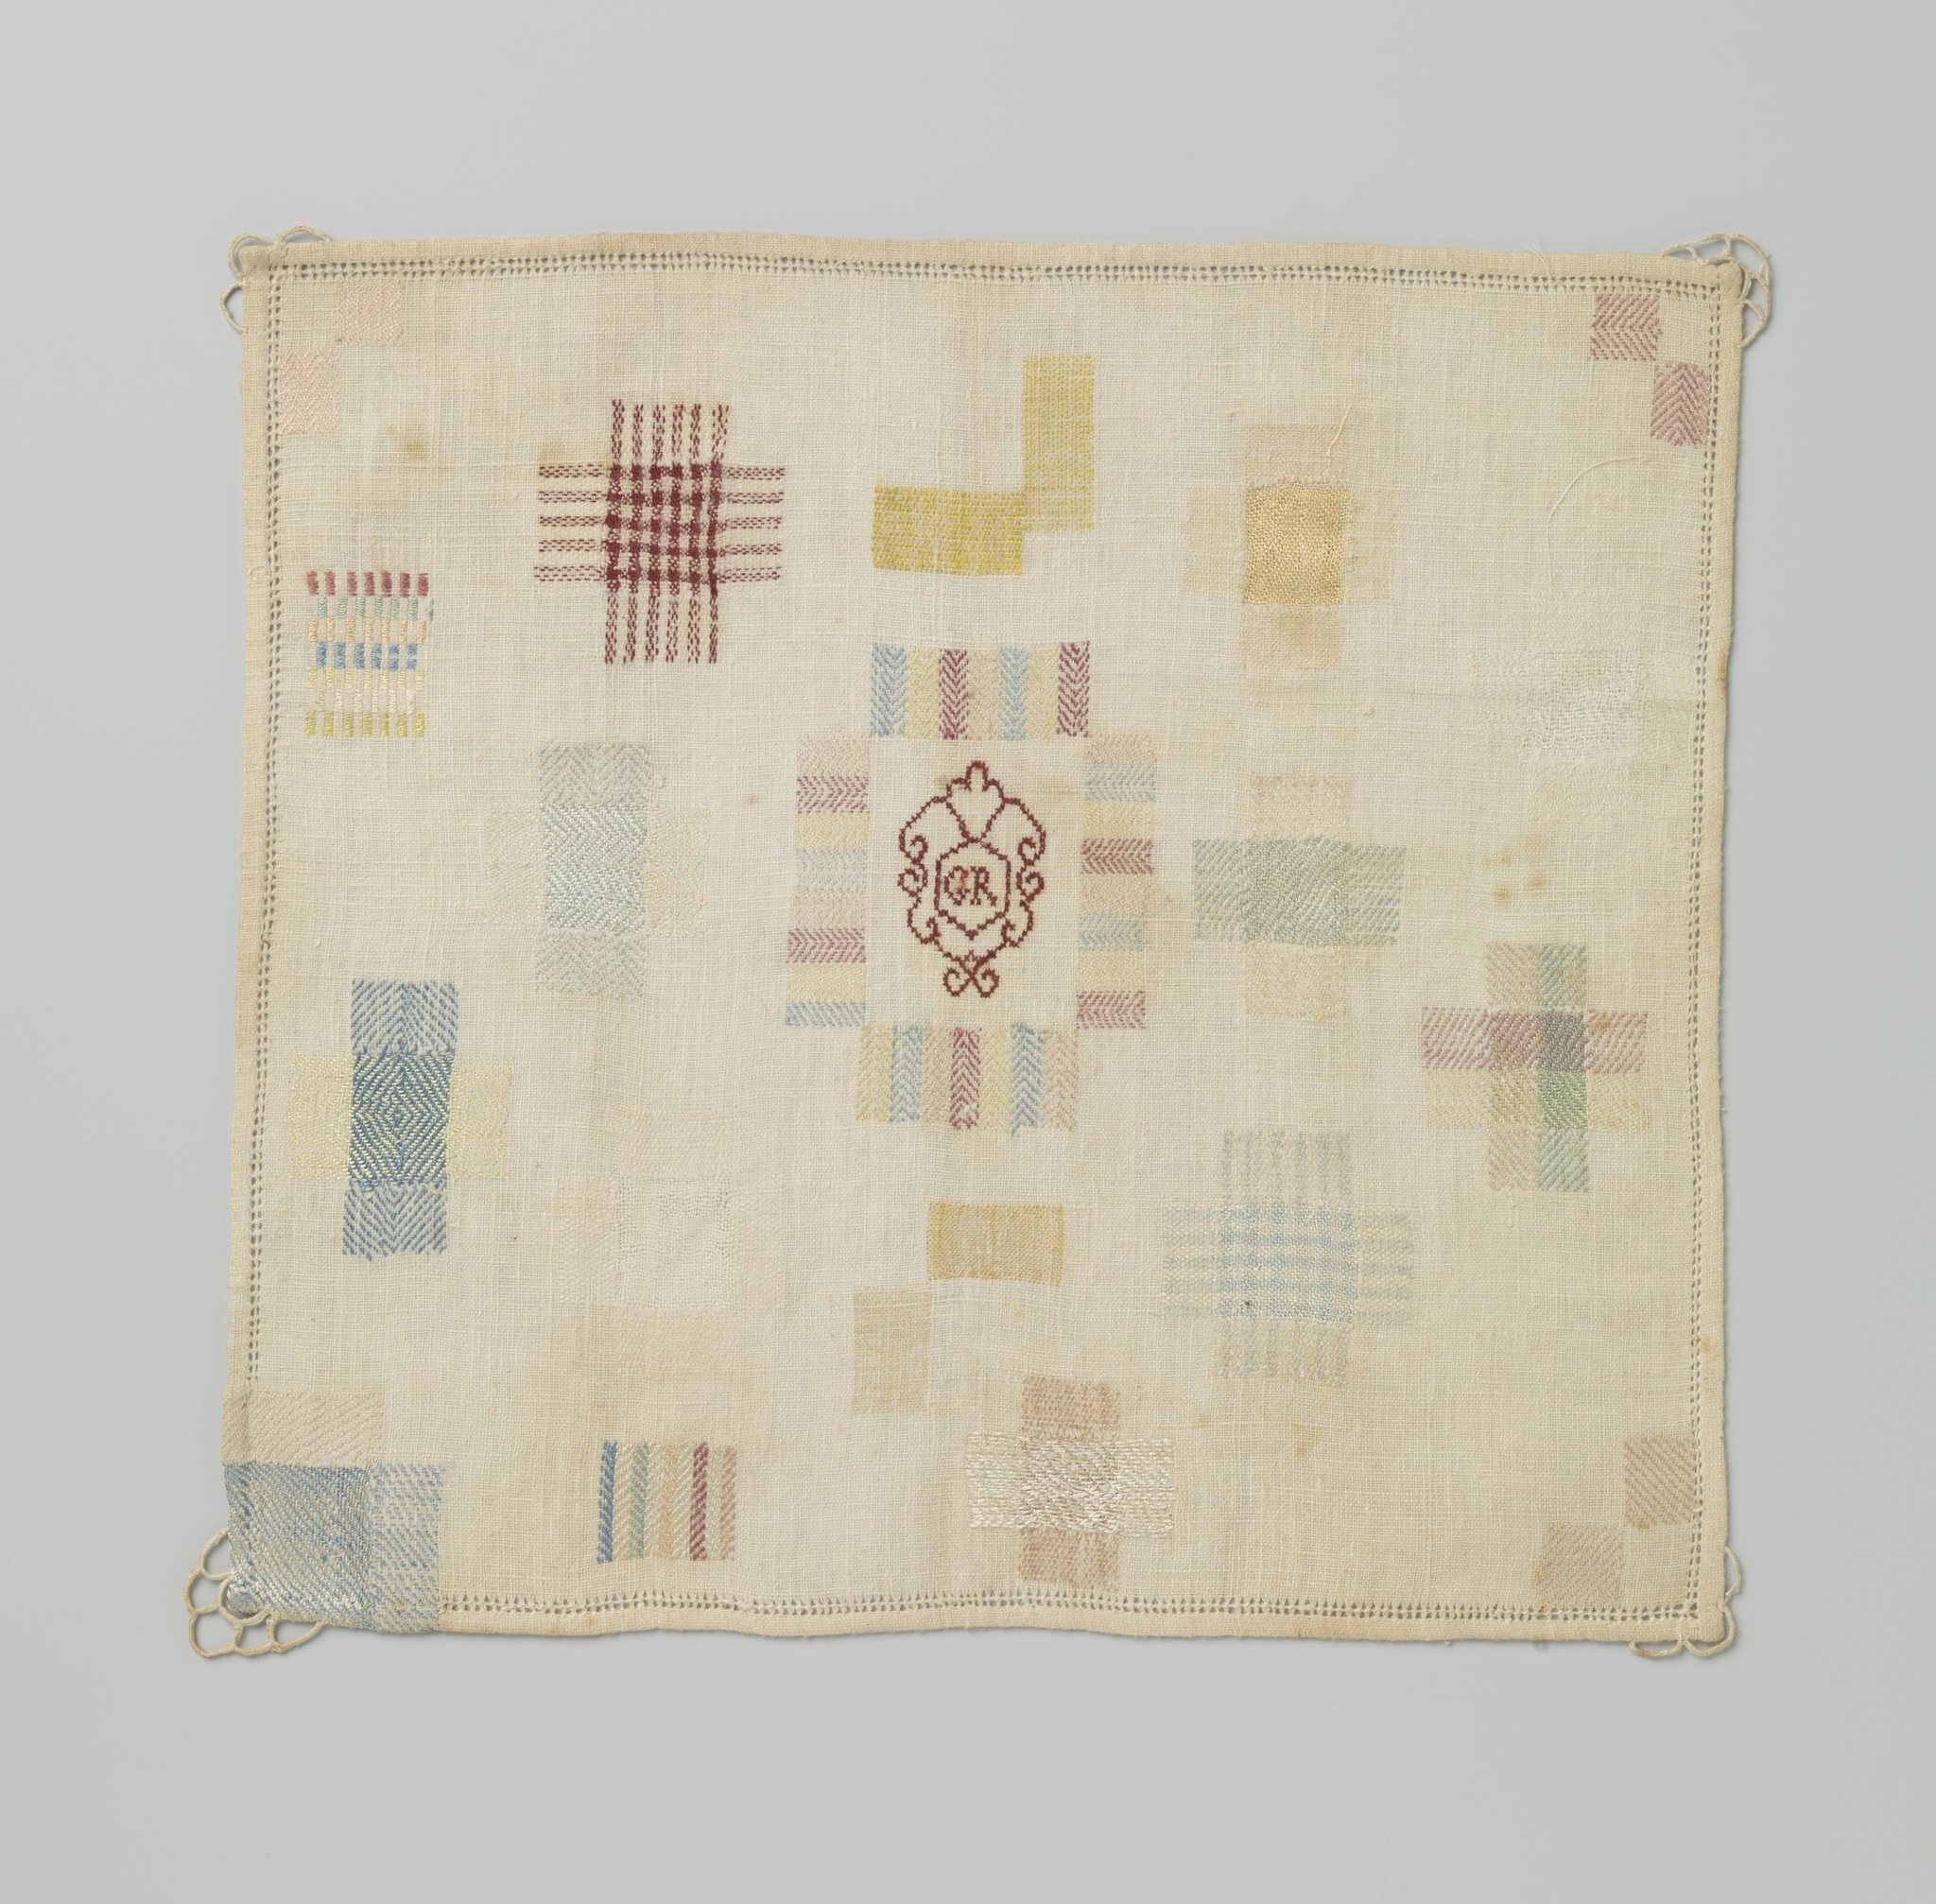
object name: stoplap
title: Stoplap van veelkleurige zijde op linnen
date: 1760-1770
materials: linen, silk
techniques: embroidered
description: Stoplap met borduurwerk. Het borduurwerk heeft de initialen GR in een wapenbord. De rand is uitgewerkt.